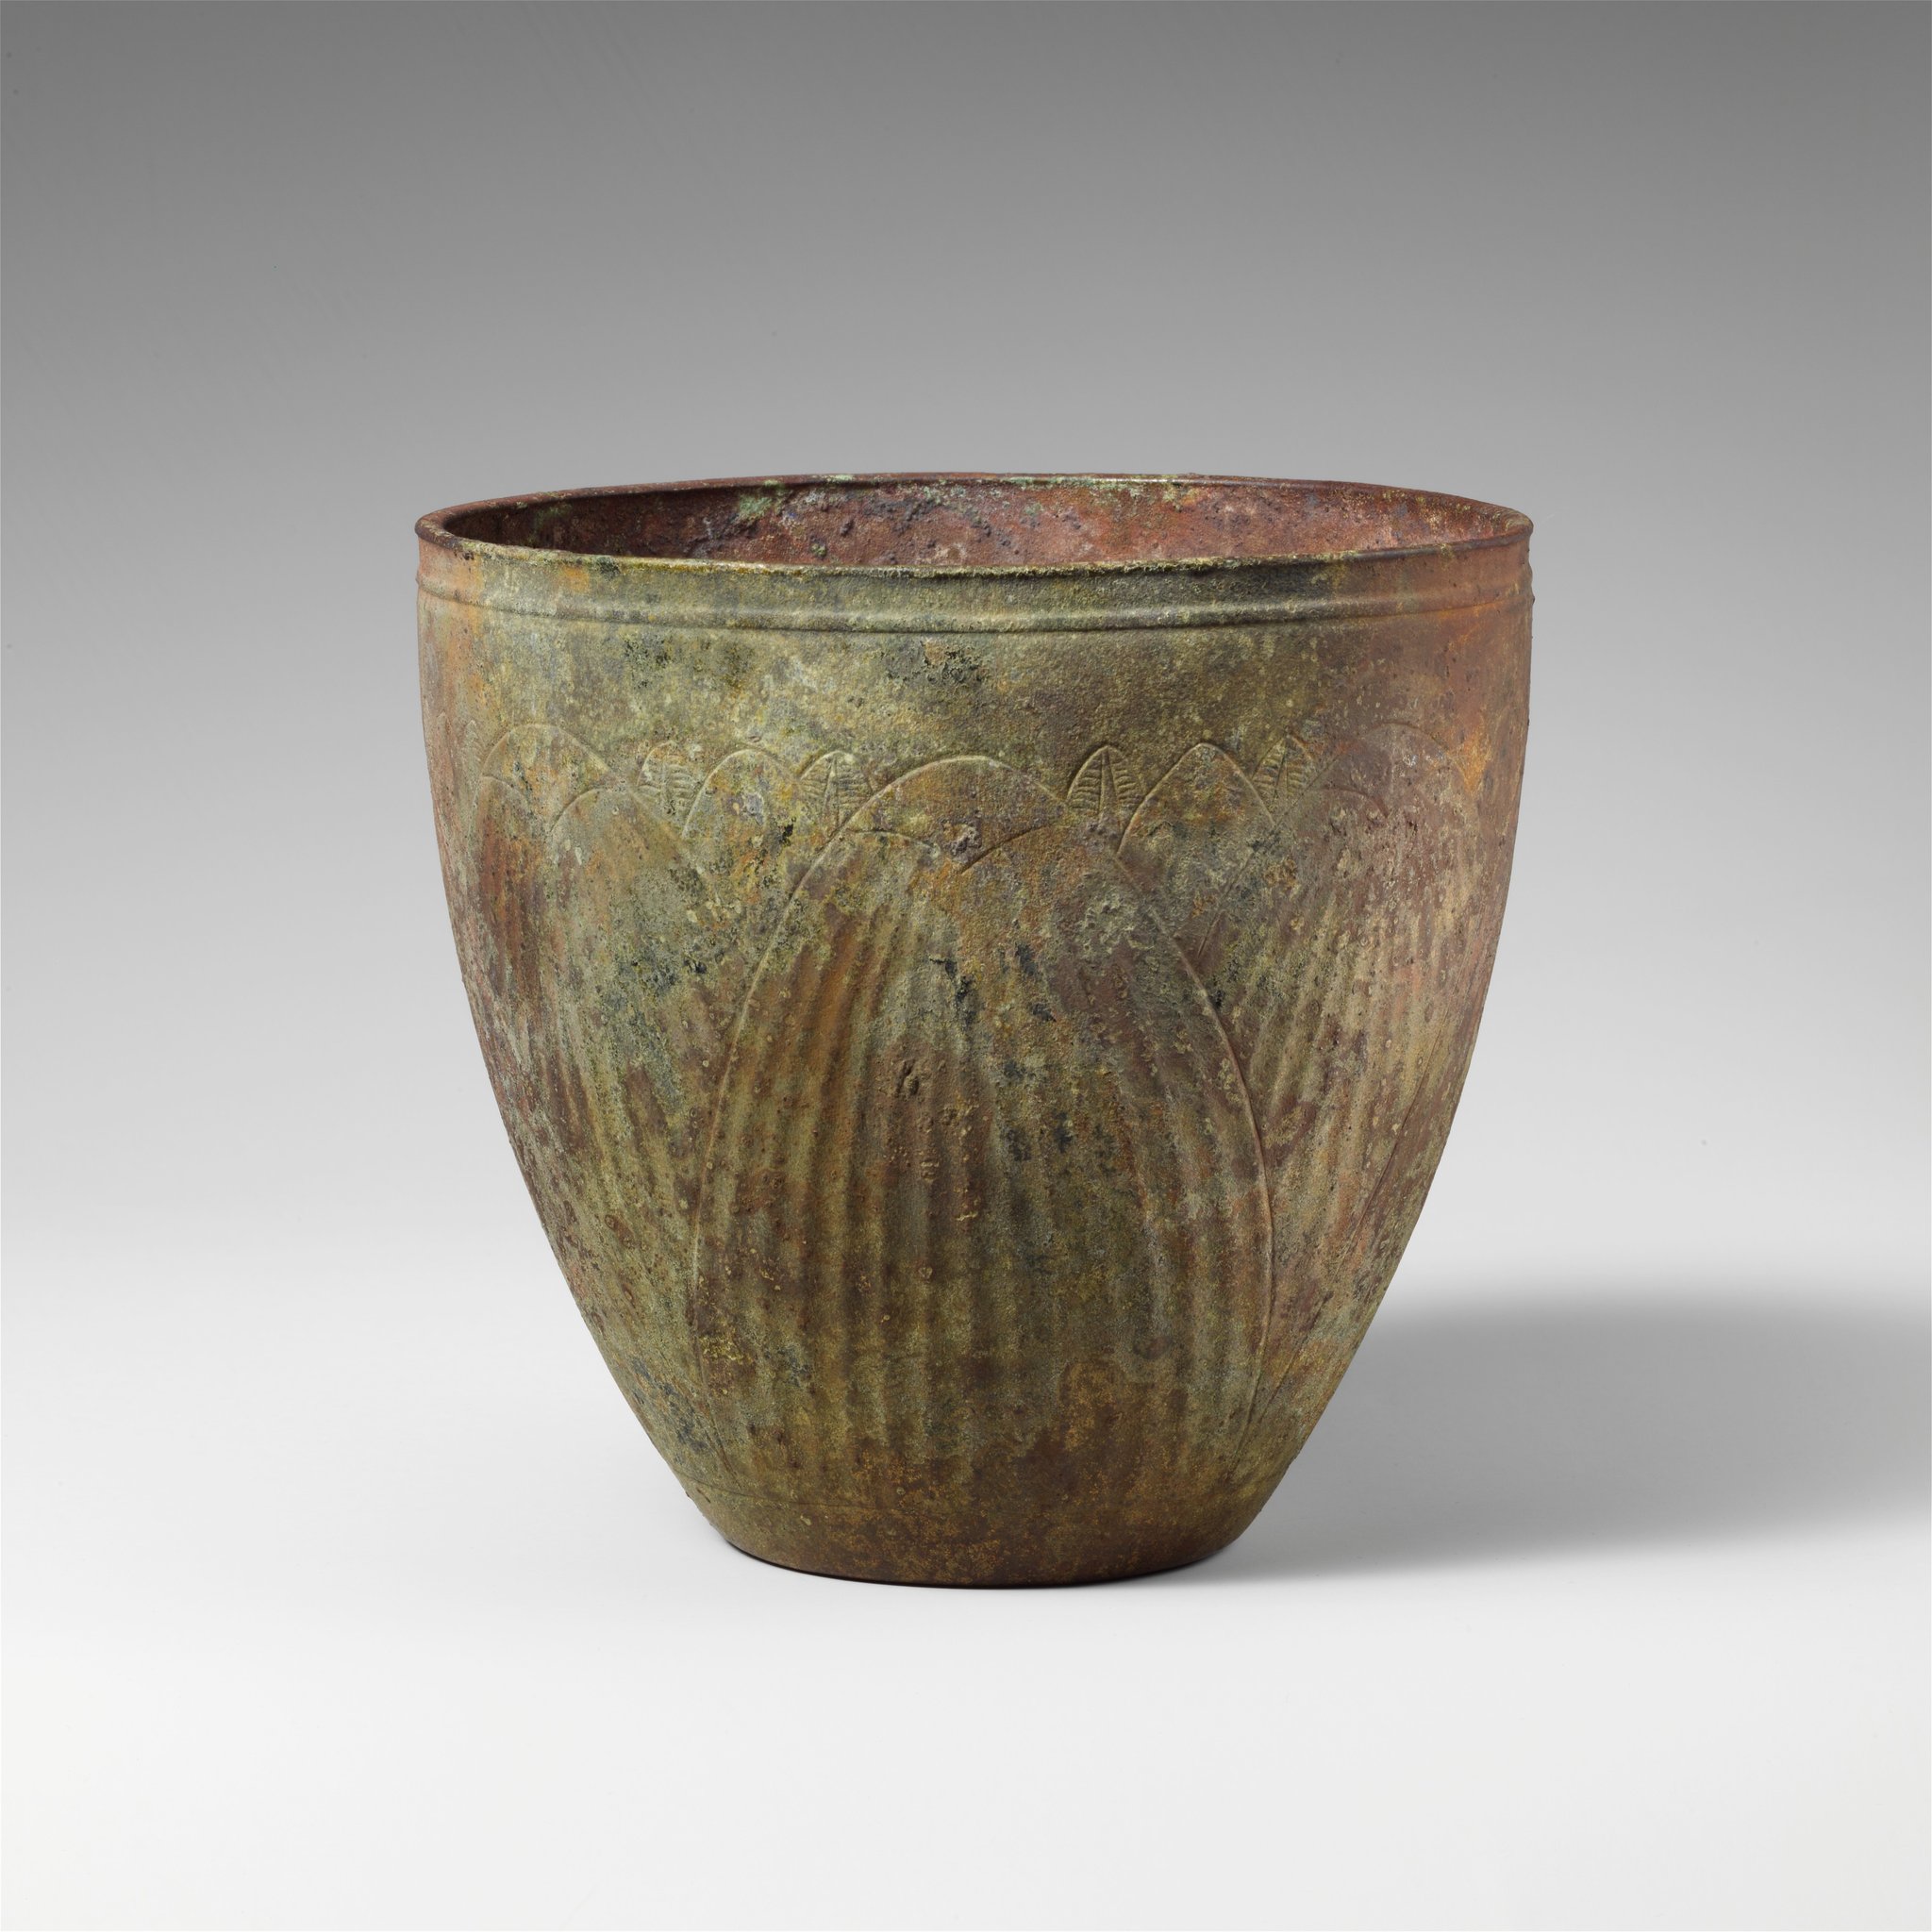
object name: beaker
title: Bronze beaker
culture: greek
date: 500-301 BCE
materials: bronze